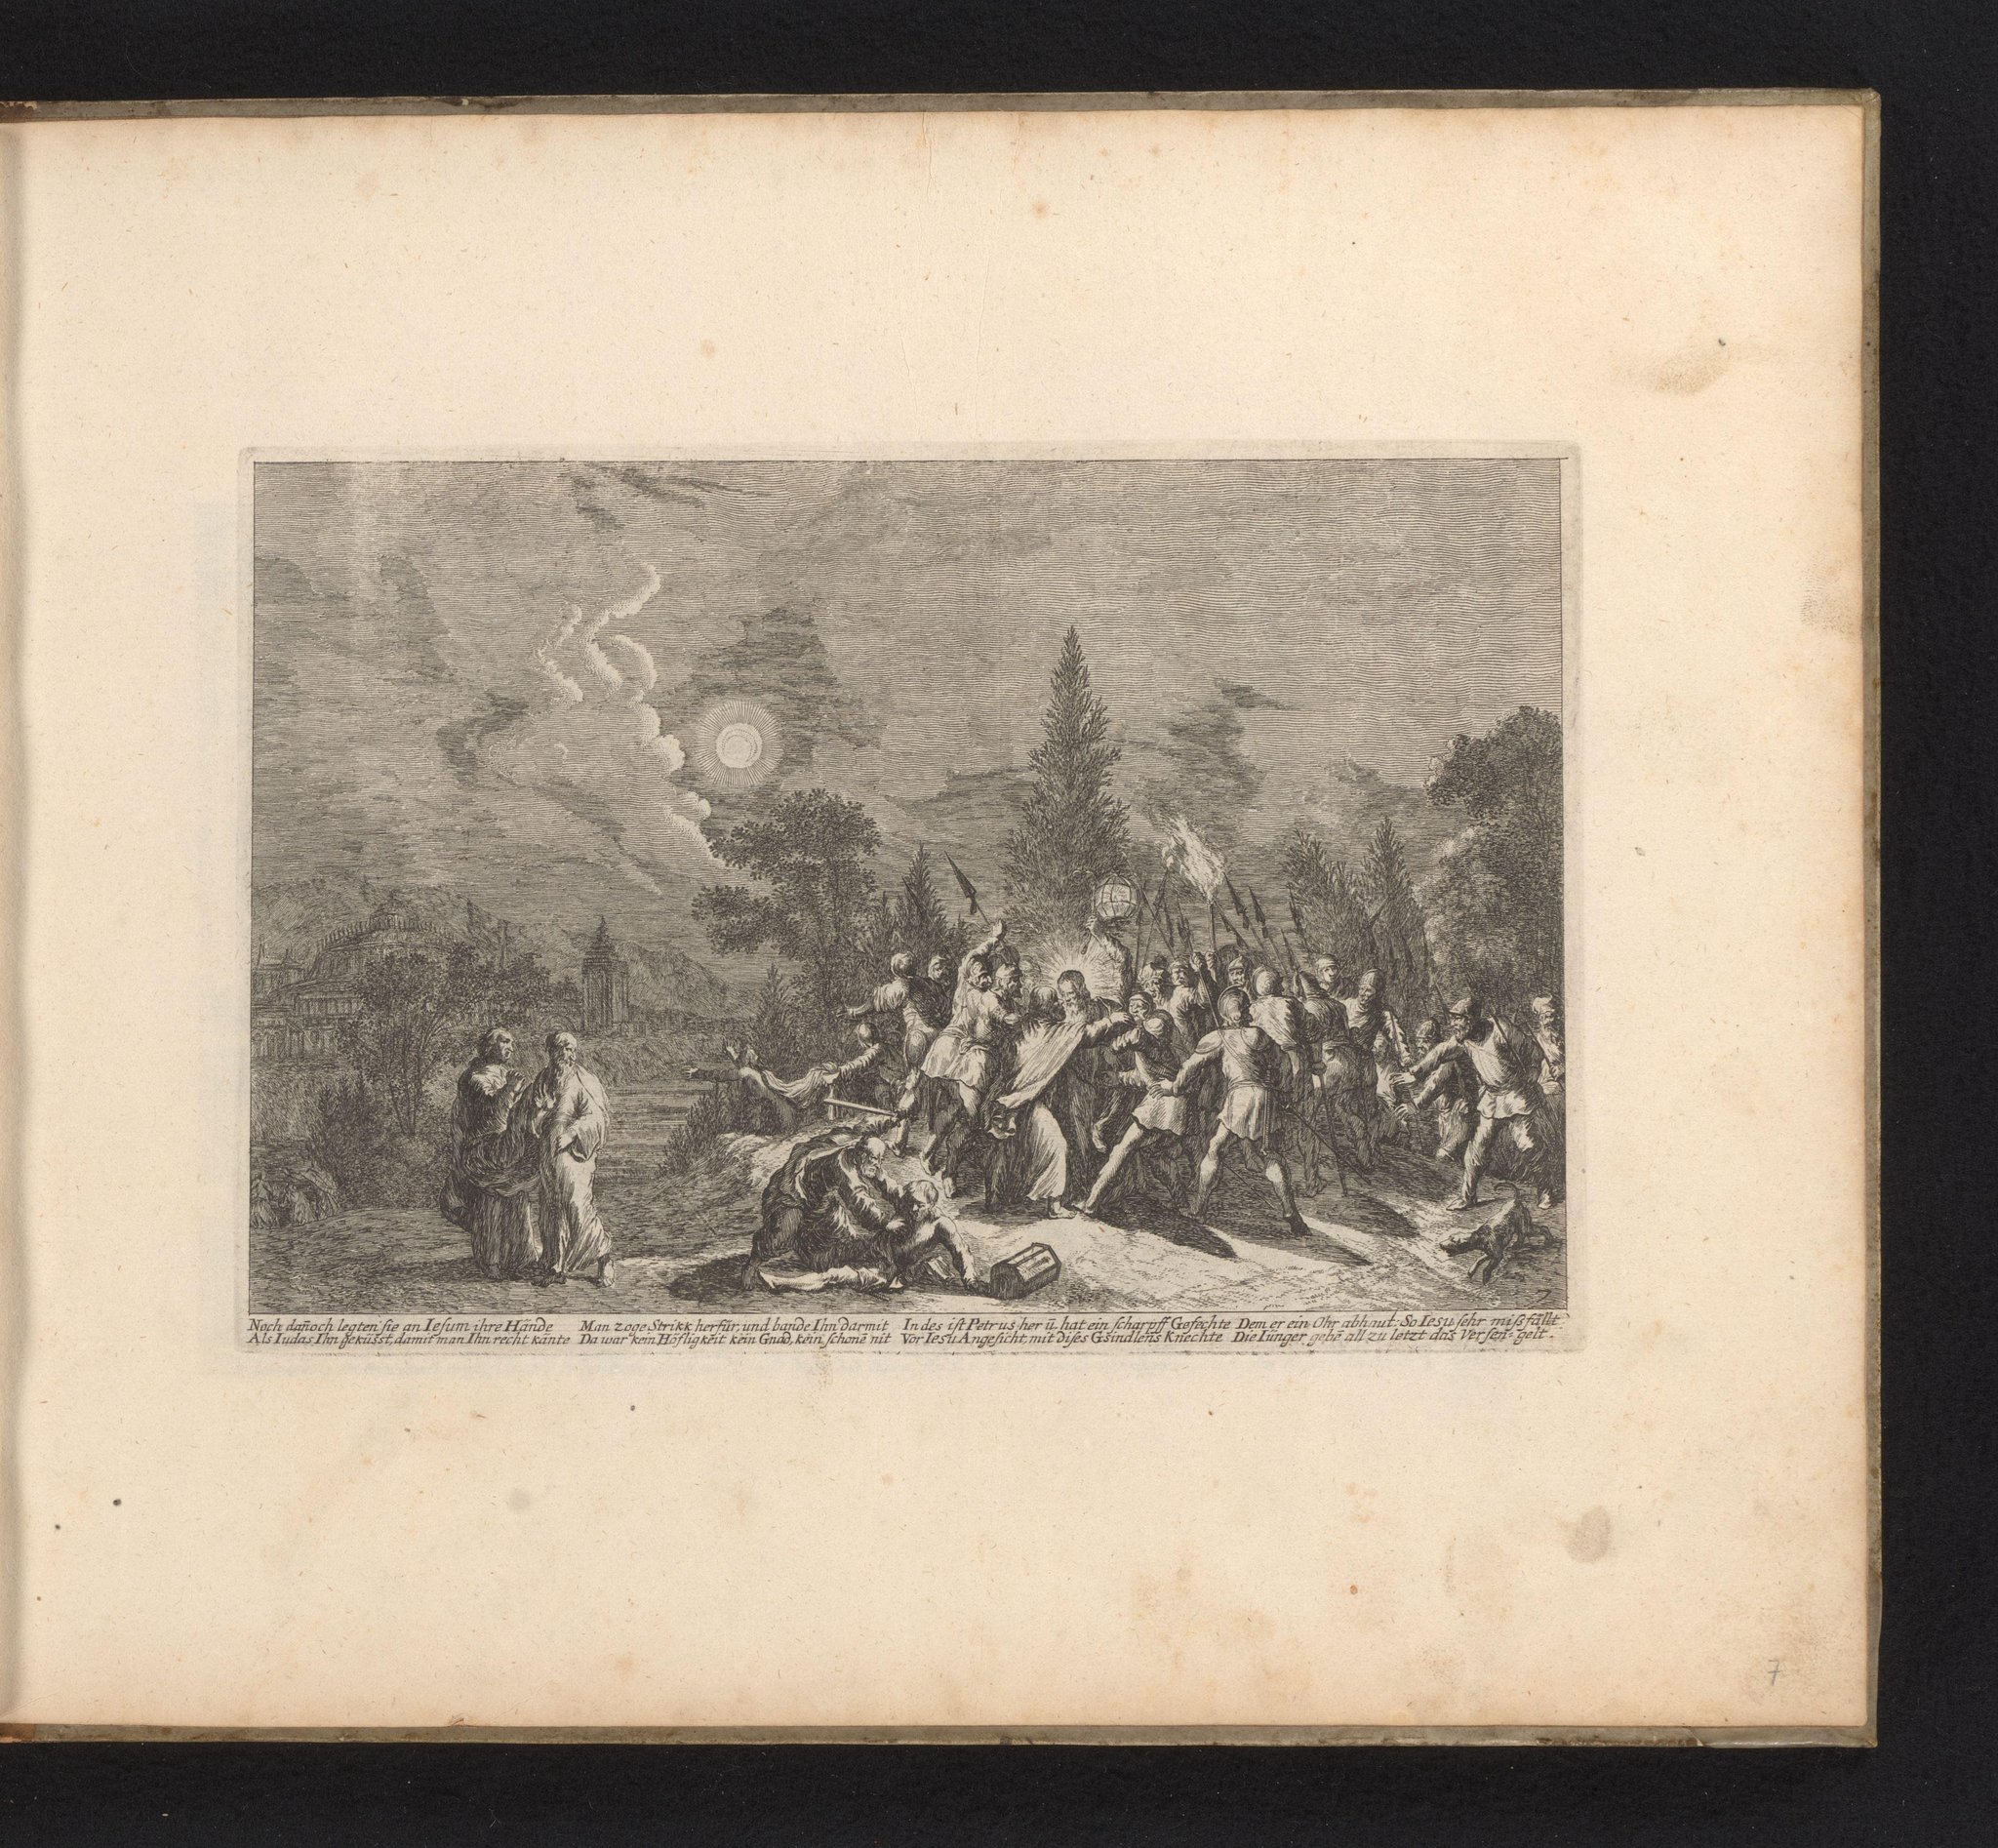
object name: print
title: Judaskus en gevangenneming van Christus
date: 1670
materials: paper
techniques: etching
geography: augsburg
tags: the kiss of judas: accompanied by soldiers with torches and lanterns, he kisses christ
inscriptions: collector's mark: Lugt 2228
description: Tekst in het Duits in de ondermarge. Rechtsonder genummerd: 7. Prent maakt deel uit van een album.